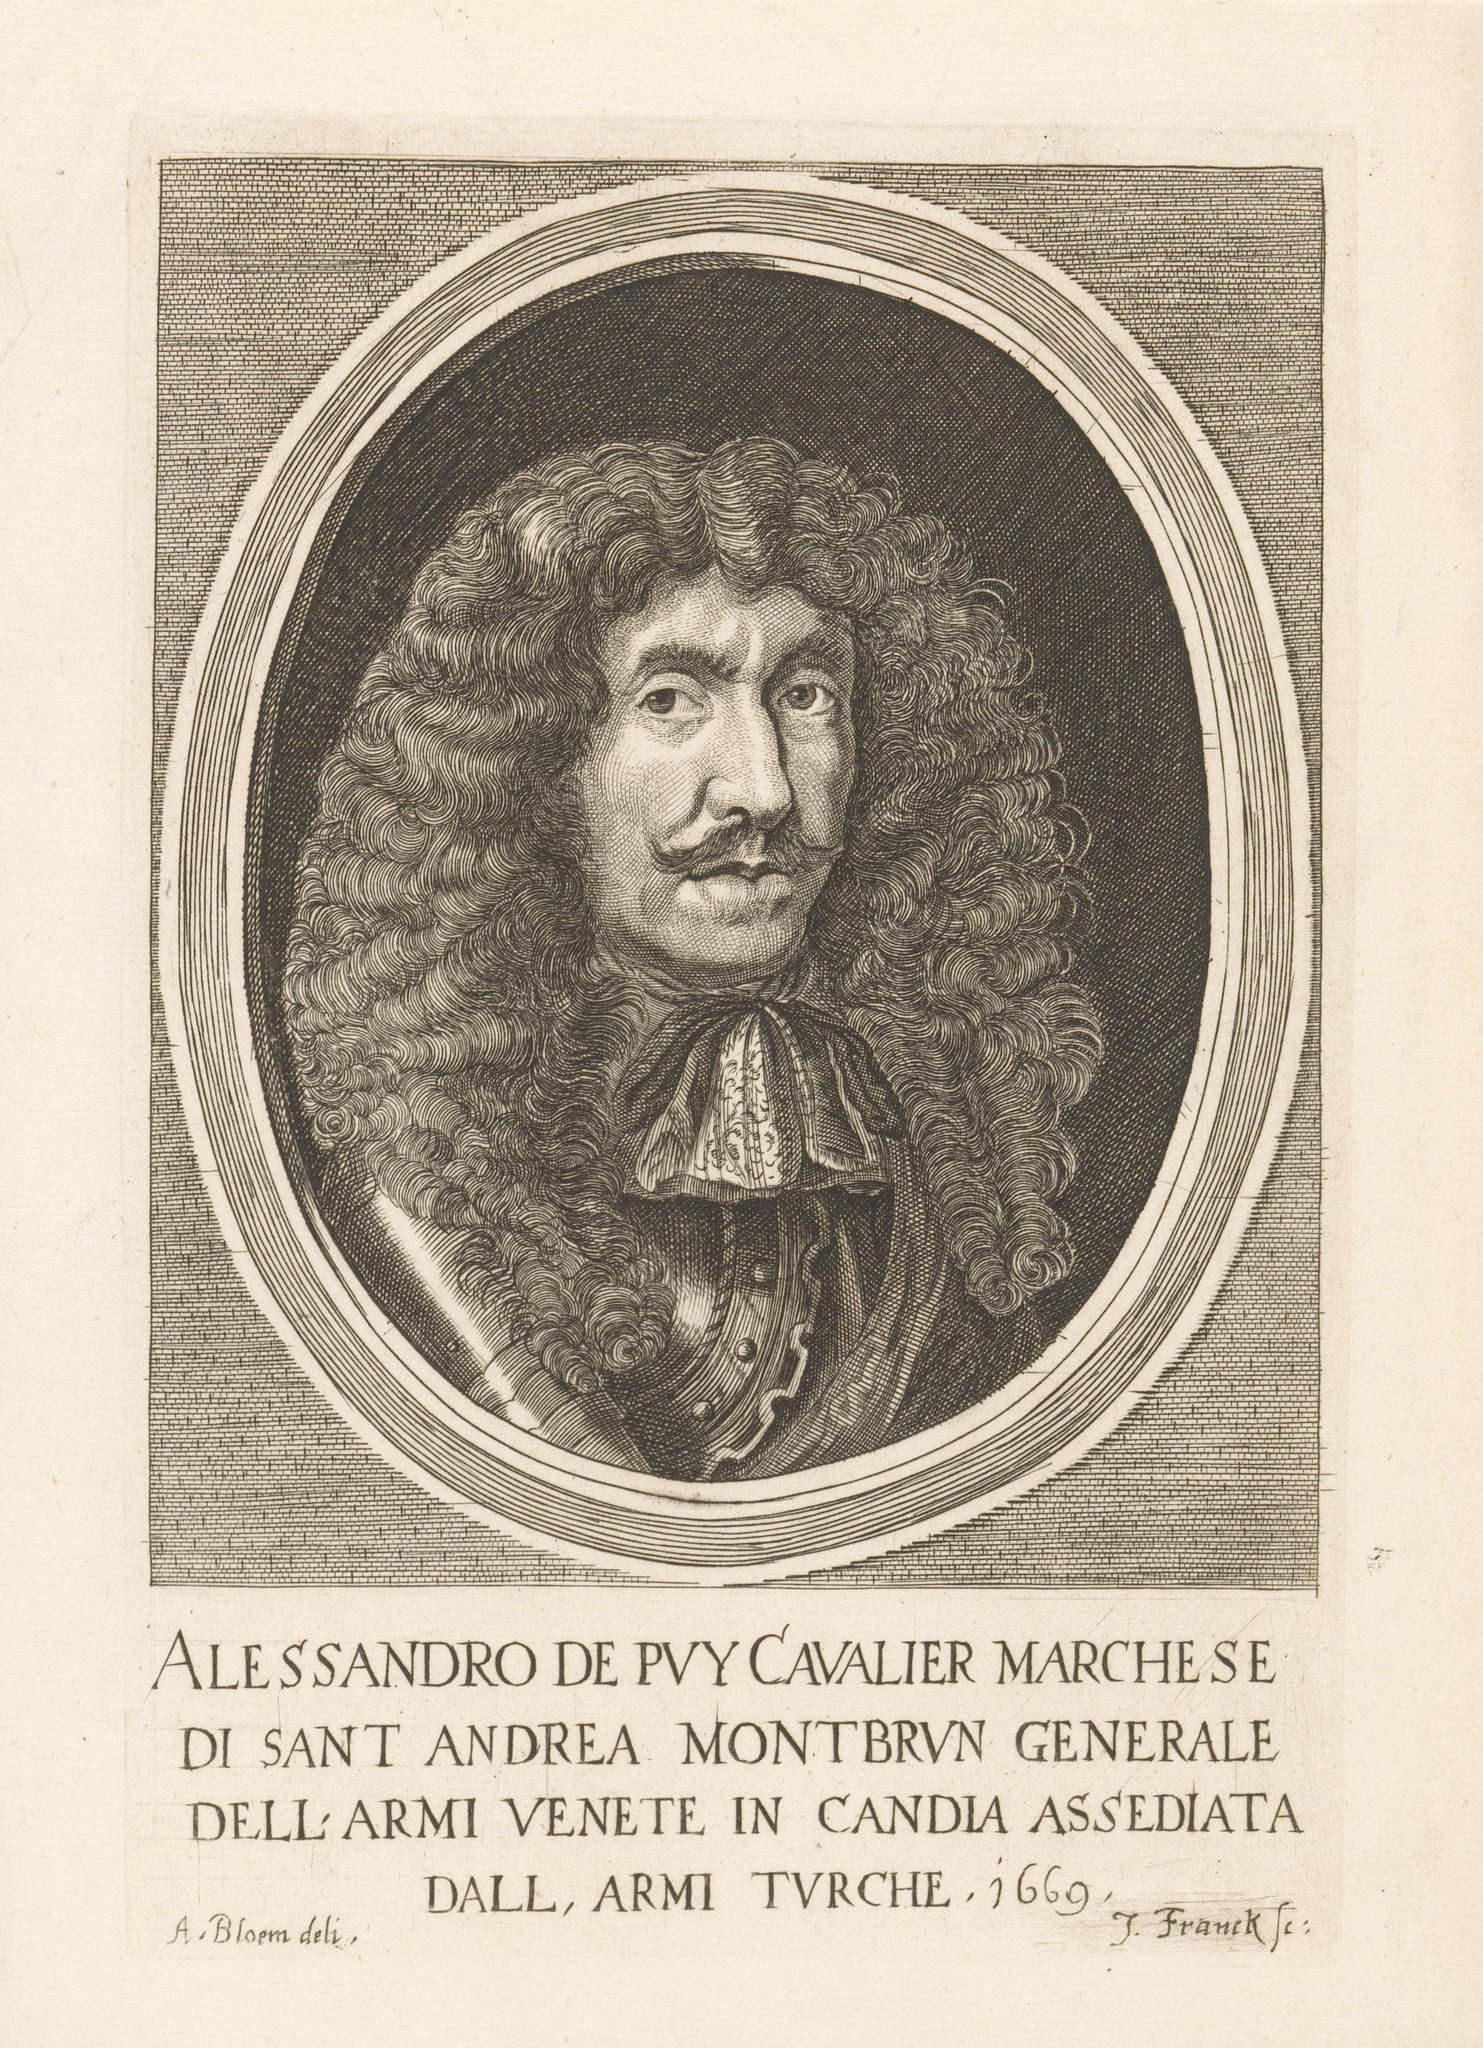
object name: print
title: Portret van Alexandre de Saint-André Dupuy-Montbrun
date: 1669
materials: paper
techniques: engraving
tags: armour, historical persons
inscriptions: collector's mark: Lugt 2228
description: Prent gebruikt voor: Priorato, Galeazzo Gualdo. Historia di Leopoldo cesare continente le cose piu memorabili successe in Europa dal 1656 sino al 1670. Wenen: Johann Baptist Hacque, 1670.